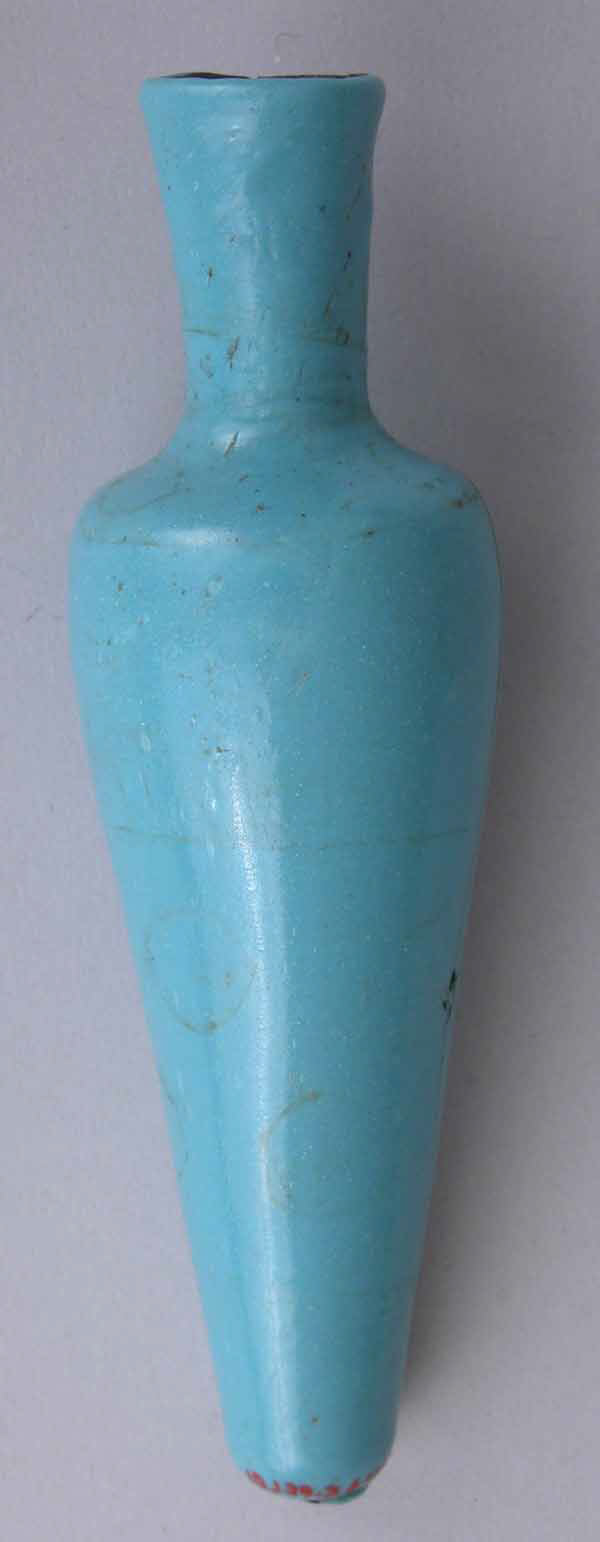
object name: bottle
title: Cosmetic Flask (Mukhula) of Opaque Turquoise Glass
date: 701-900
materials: glass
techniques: glassblowing, painting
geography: egypt